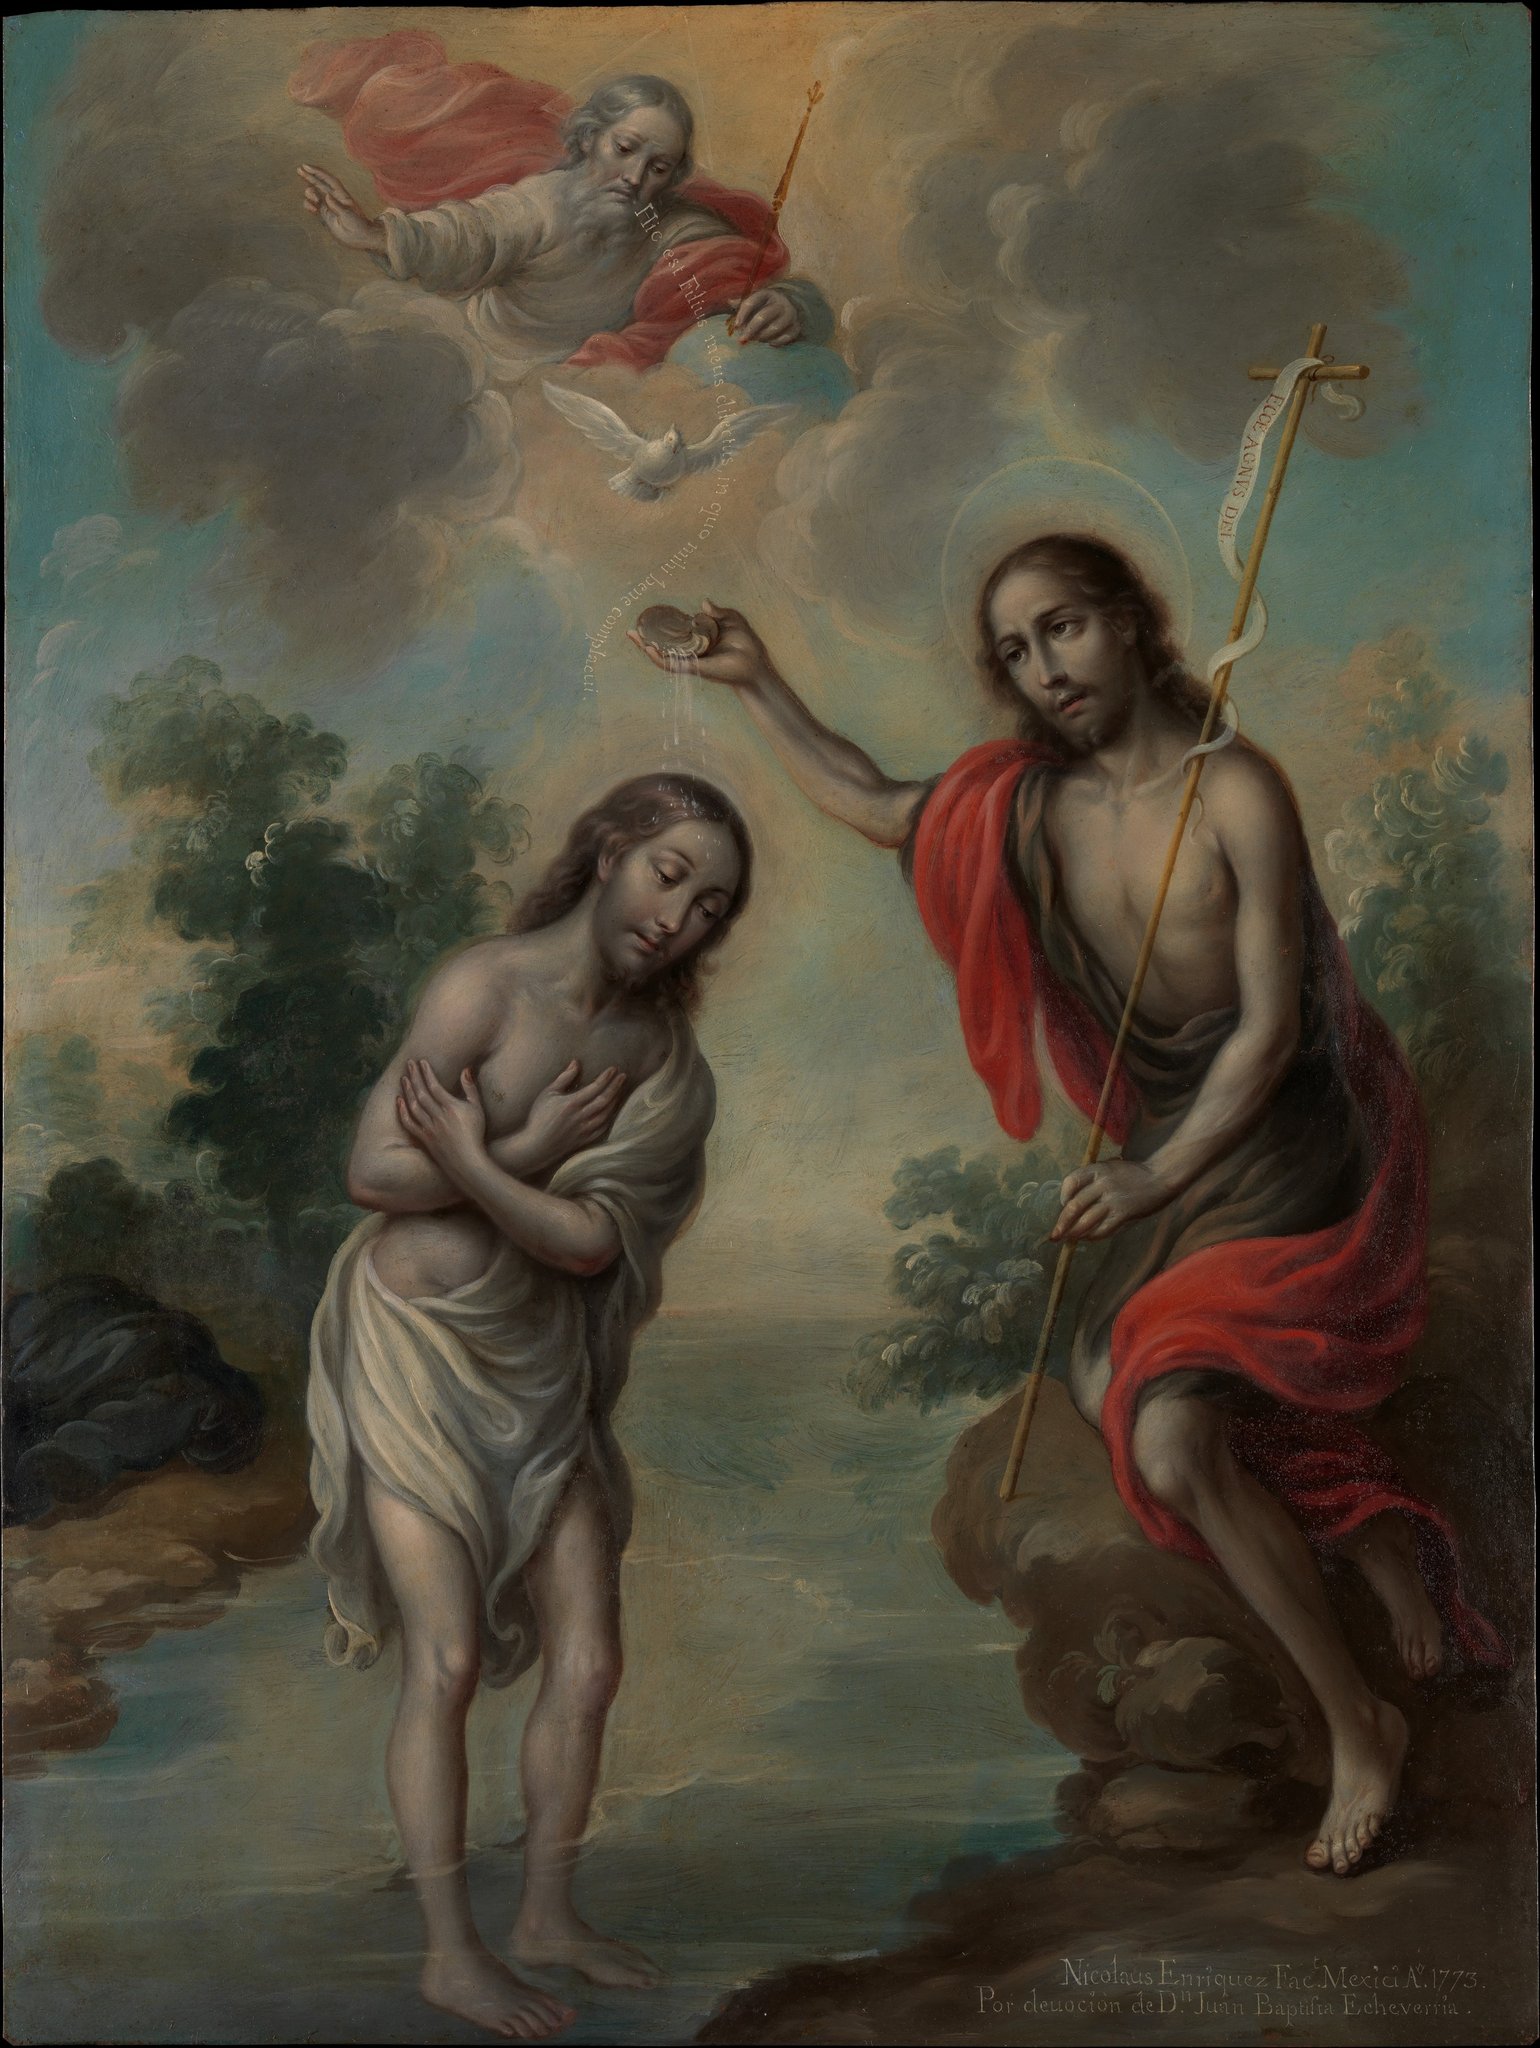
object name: painting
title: The Baptism of Christ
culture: mexican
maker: nicolás enríquez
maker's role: artist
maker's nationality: mexican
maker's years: 1704-1795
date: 1773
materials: copper, oil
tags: saint john the baptist,baptism of christ